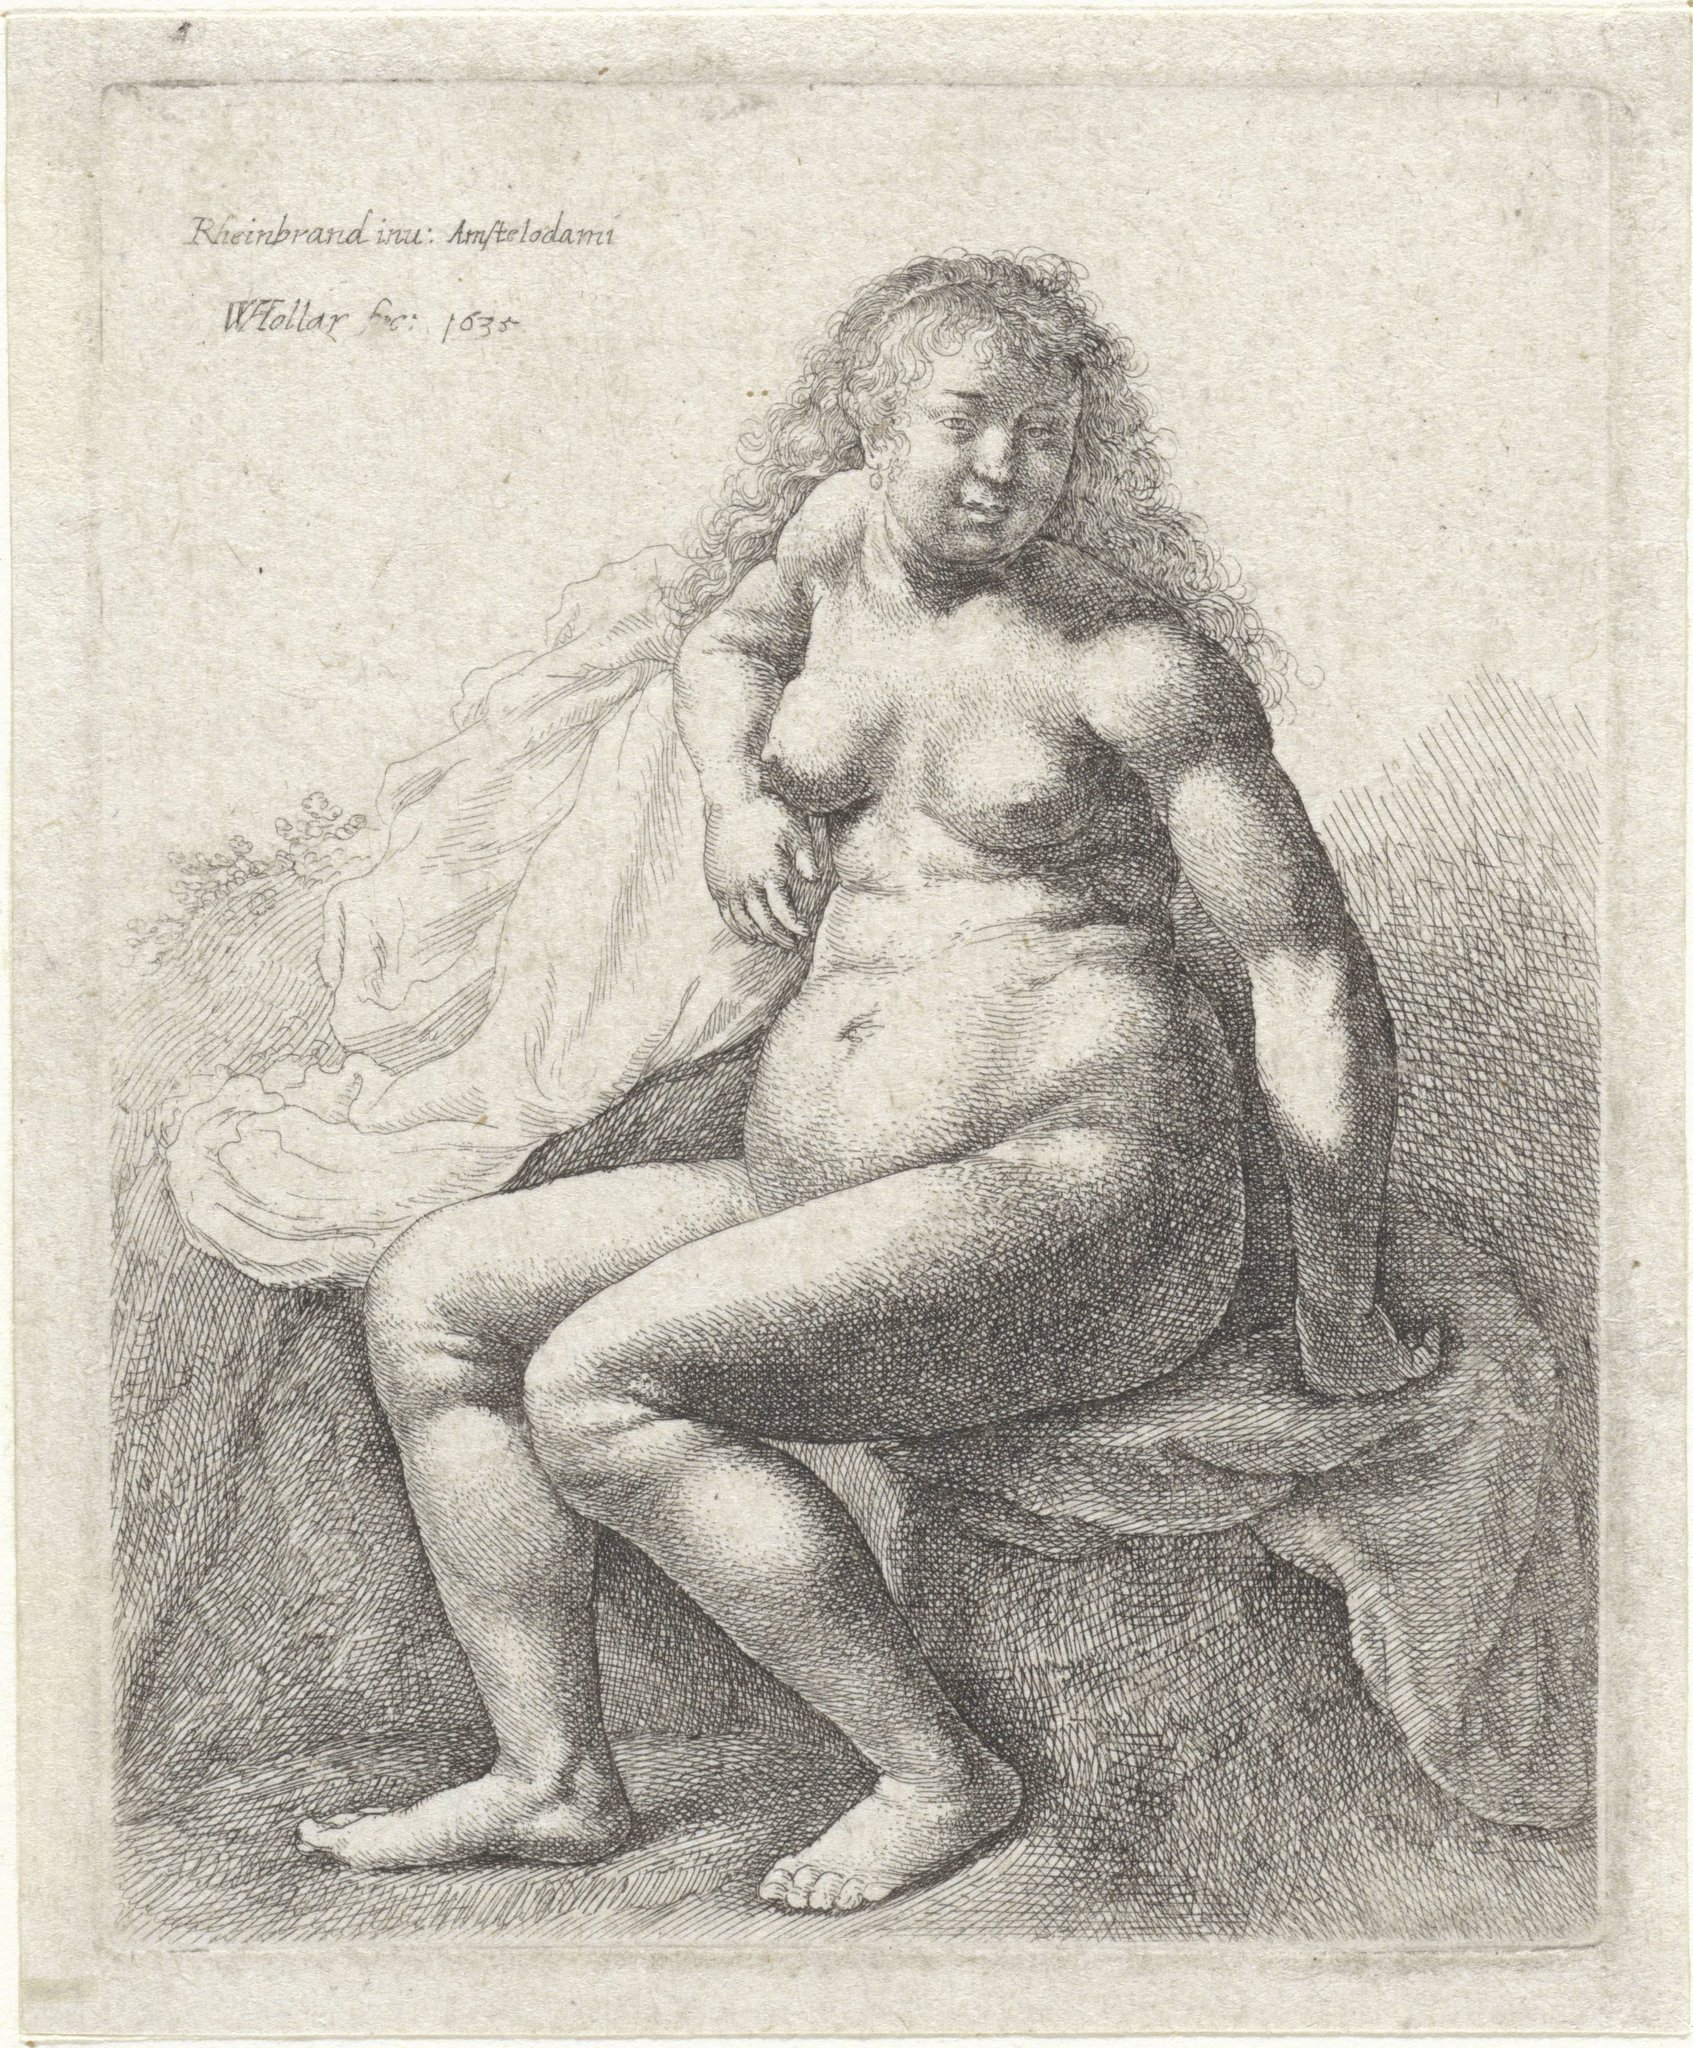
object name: print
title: Naakte vrouw, gezeten op een verhoging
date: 1635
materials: paper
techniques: etching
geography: germany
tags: the (nude) human figure; 'corpo humano' (ripa) (+ sitting), the ages of man (+ nude human being)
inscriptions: collector's mark: Lugt 654, collector's mark: Lugt 2228